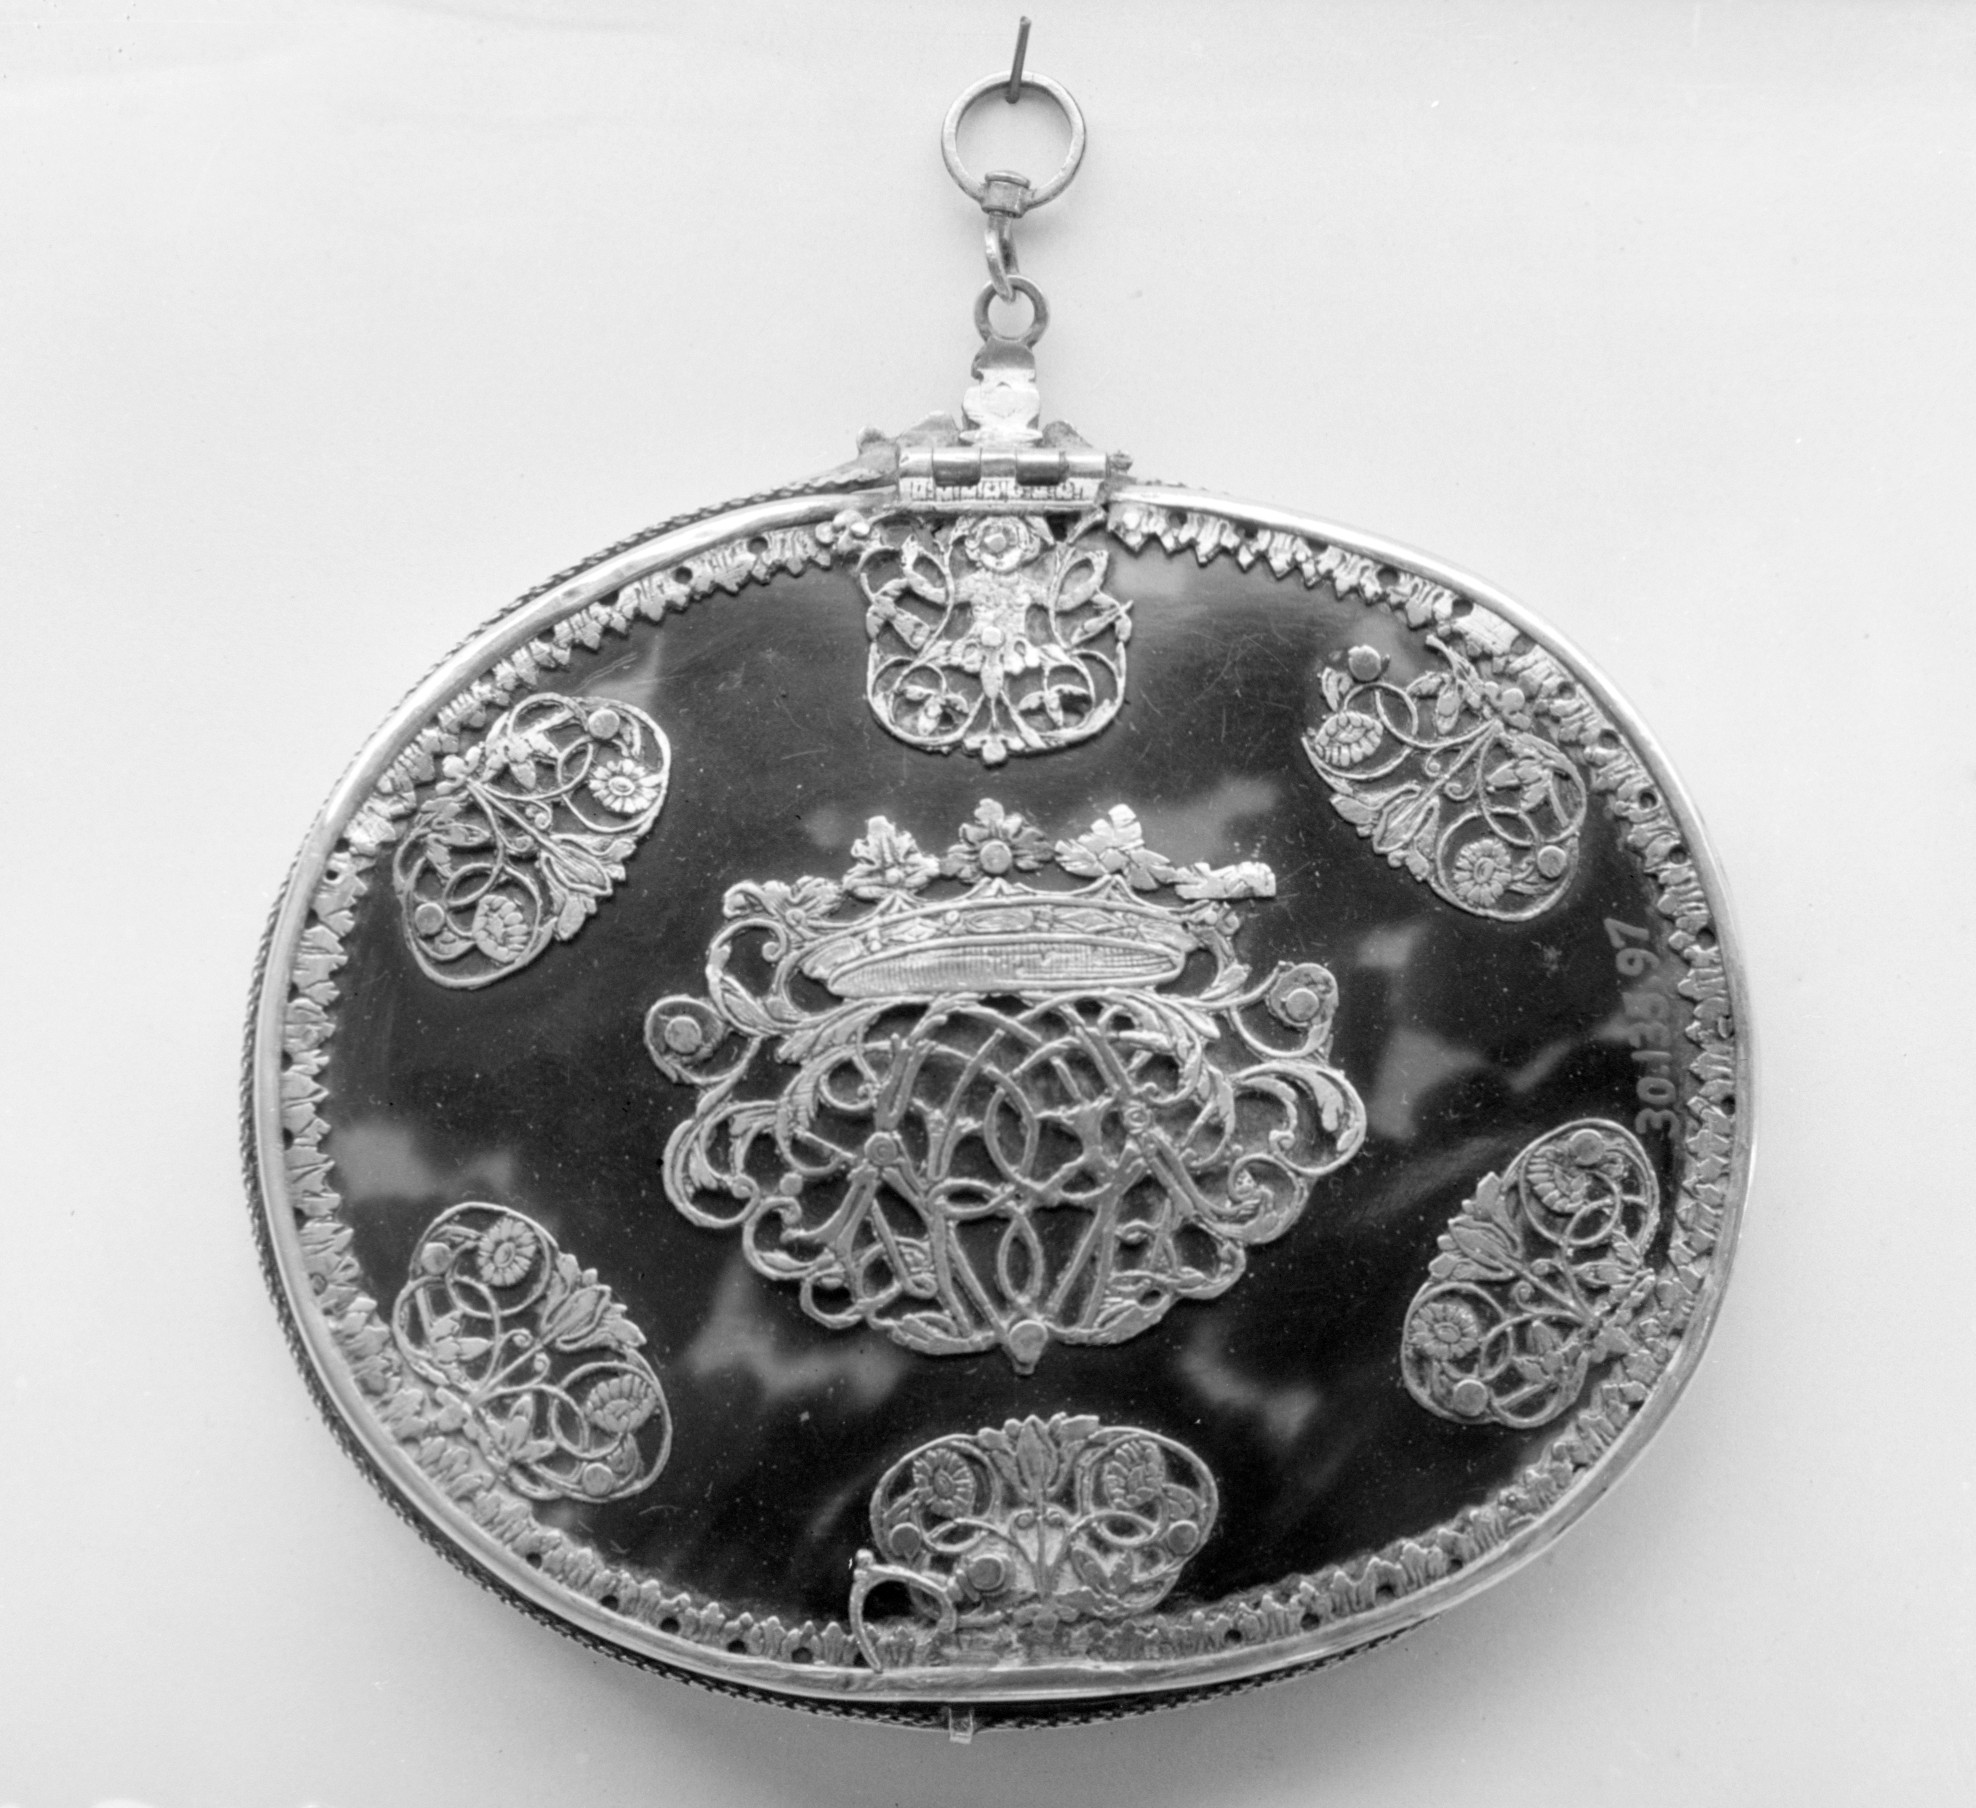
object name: mirror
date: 1651-1700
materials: glass, silver, shell